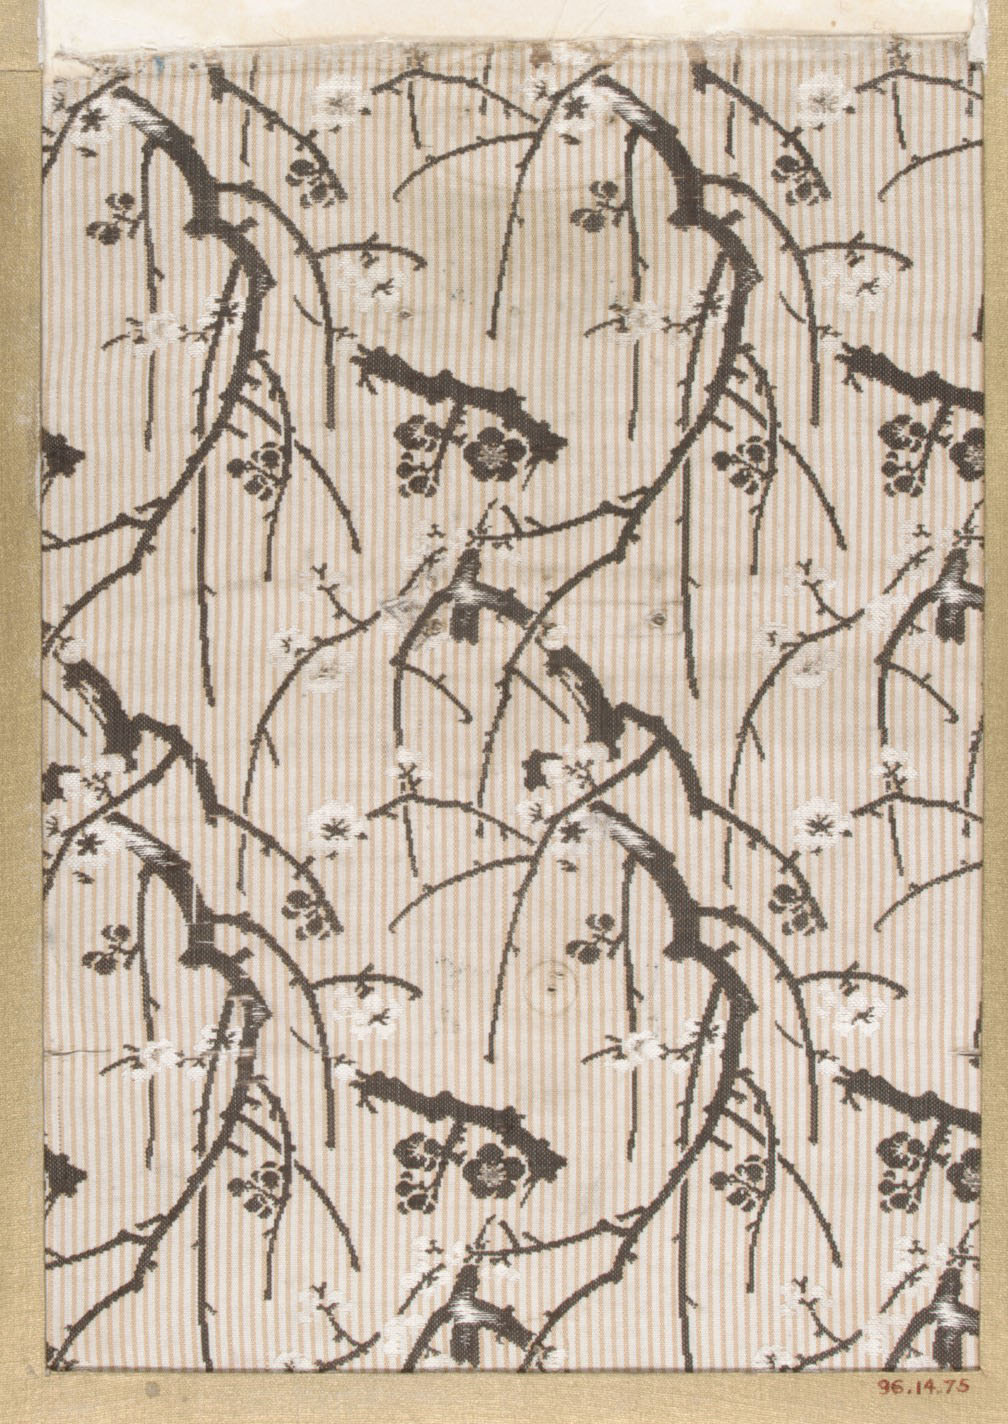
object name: piece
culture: japanese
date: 1701-1900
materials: silk